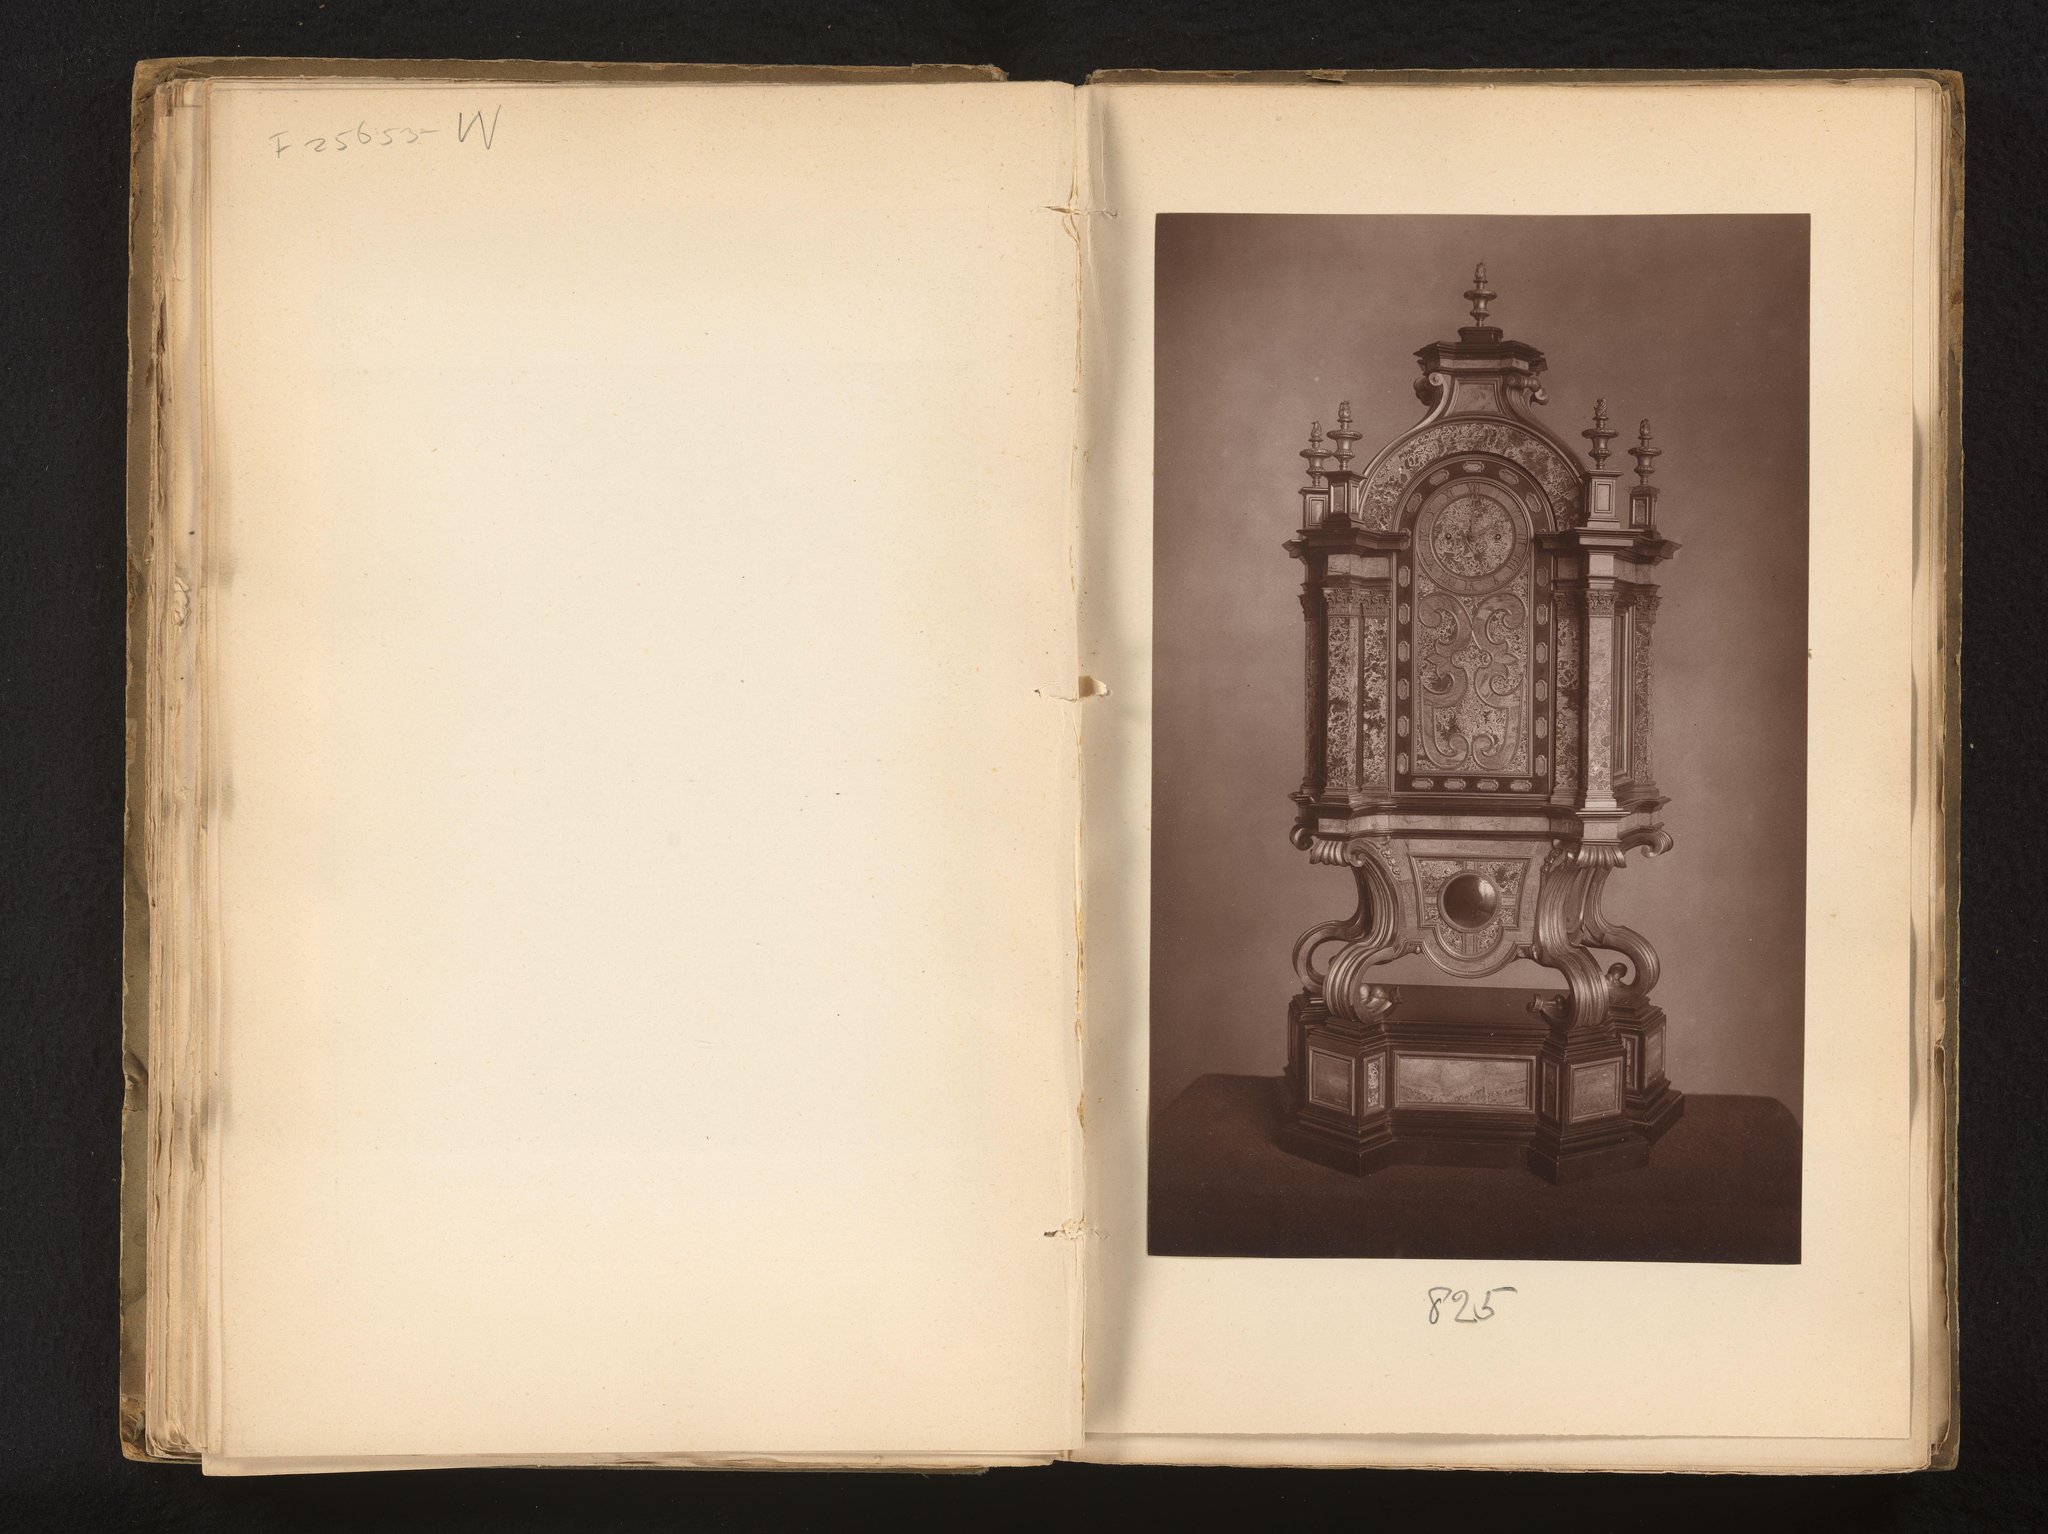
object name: page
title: Italiaanse klok, uit de collectie van Christopher Beckett Denison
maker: Anonymous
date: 1880-1885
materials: paper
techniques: woodburytype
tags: clock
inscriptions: number: ‘825’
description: Prent op negende ongenummerde pagina na pagina 82.